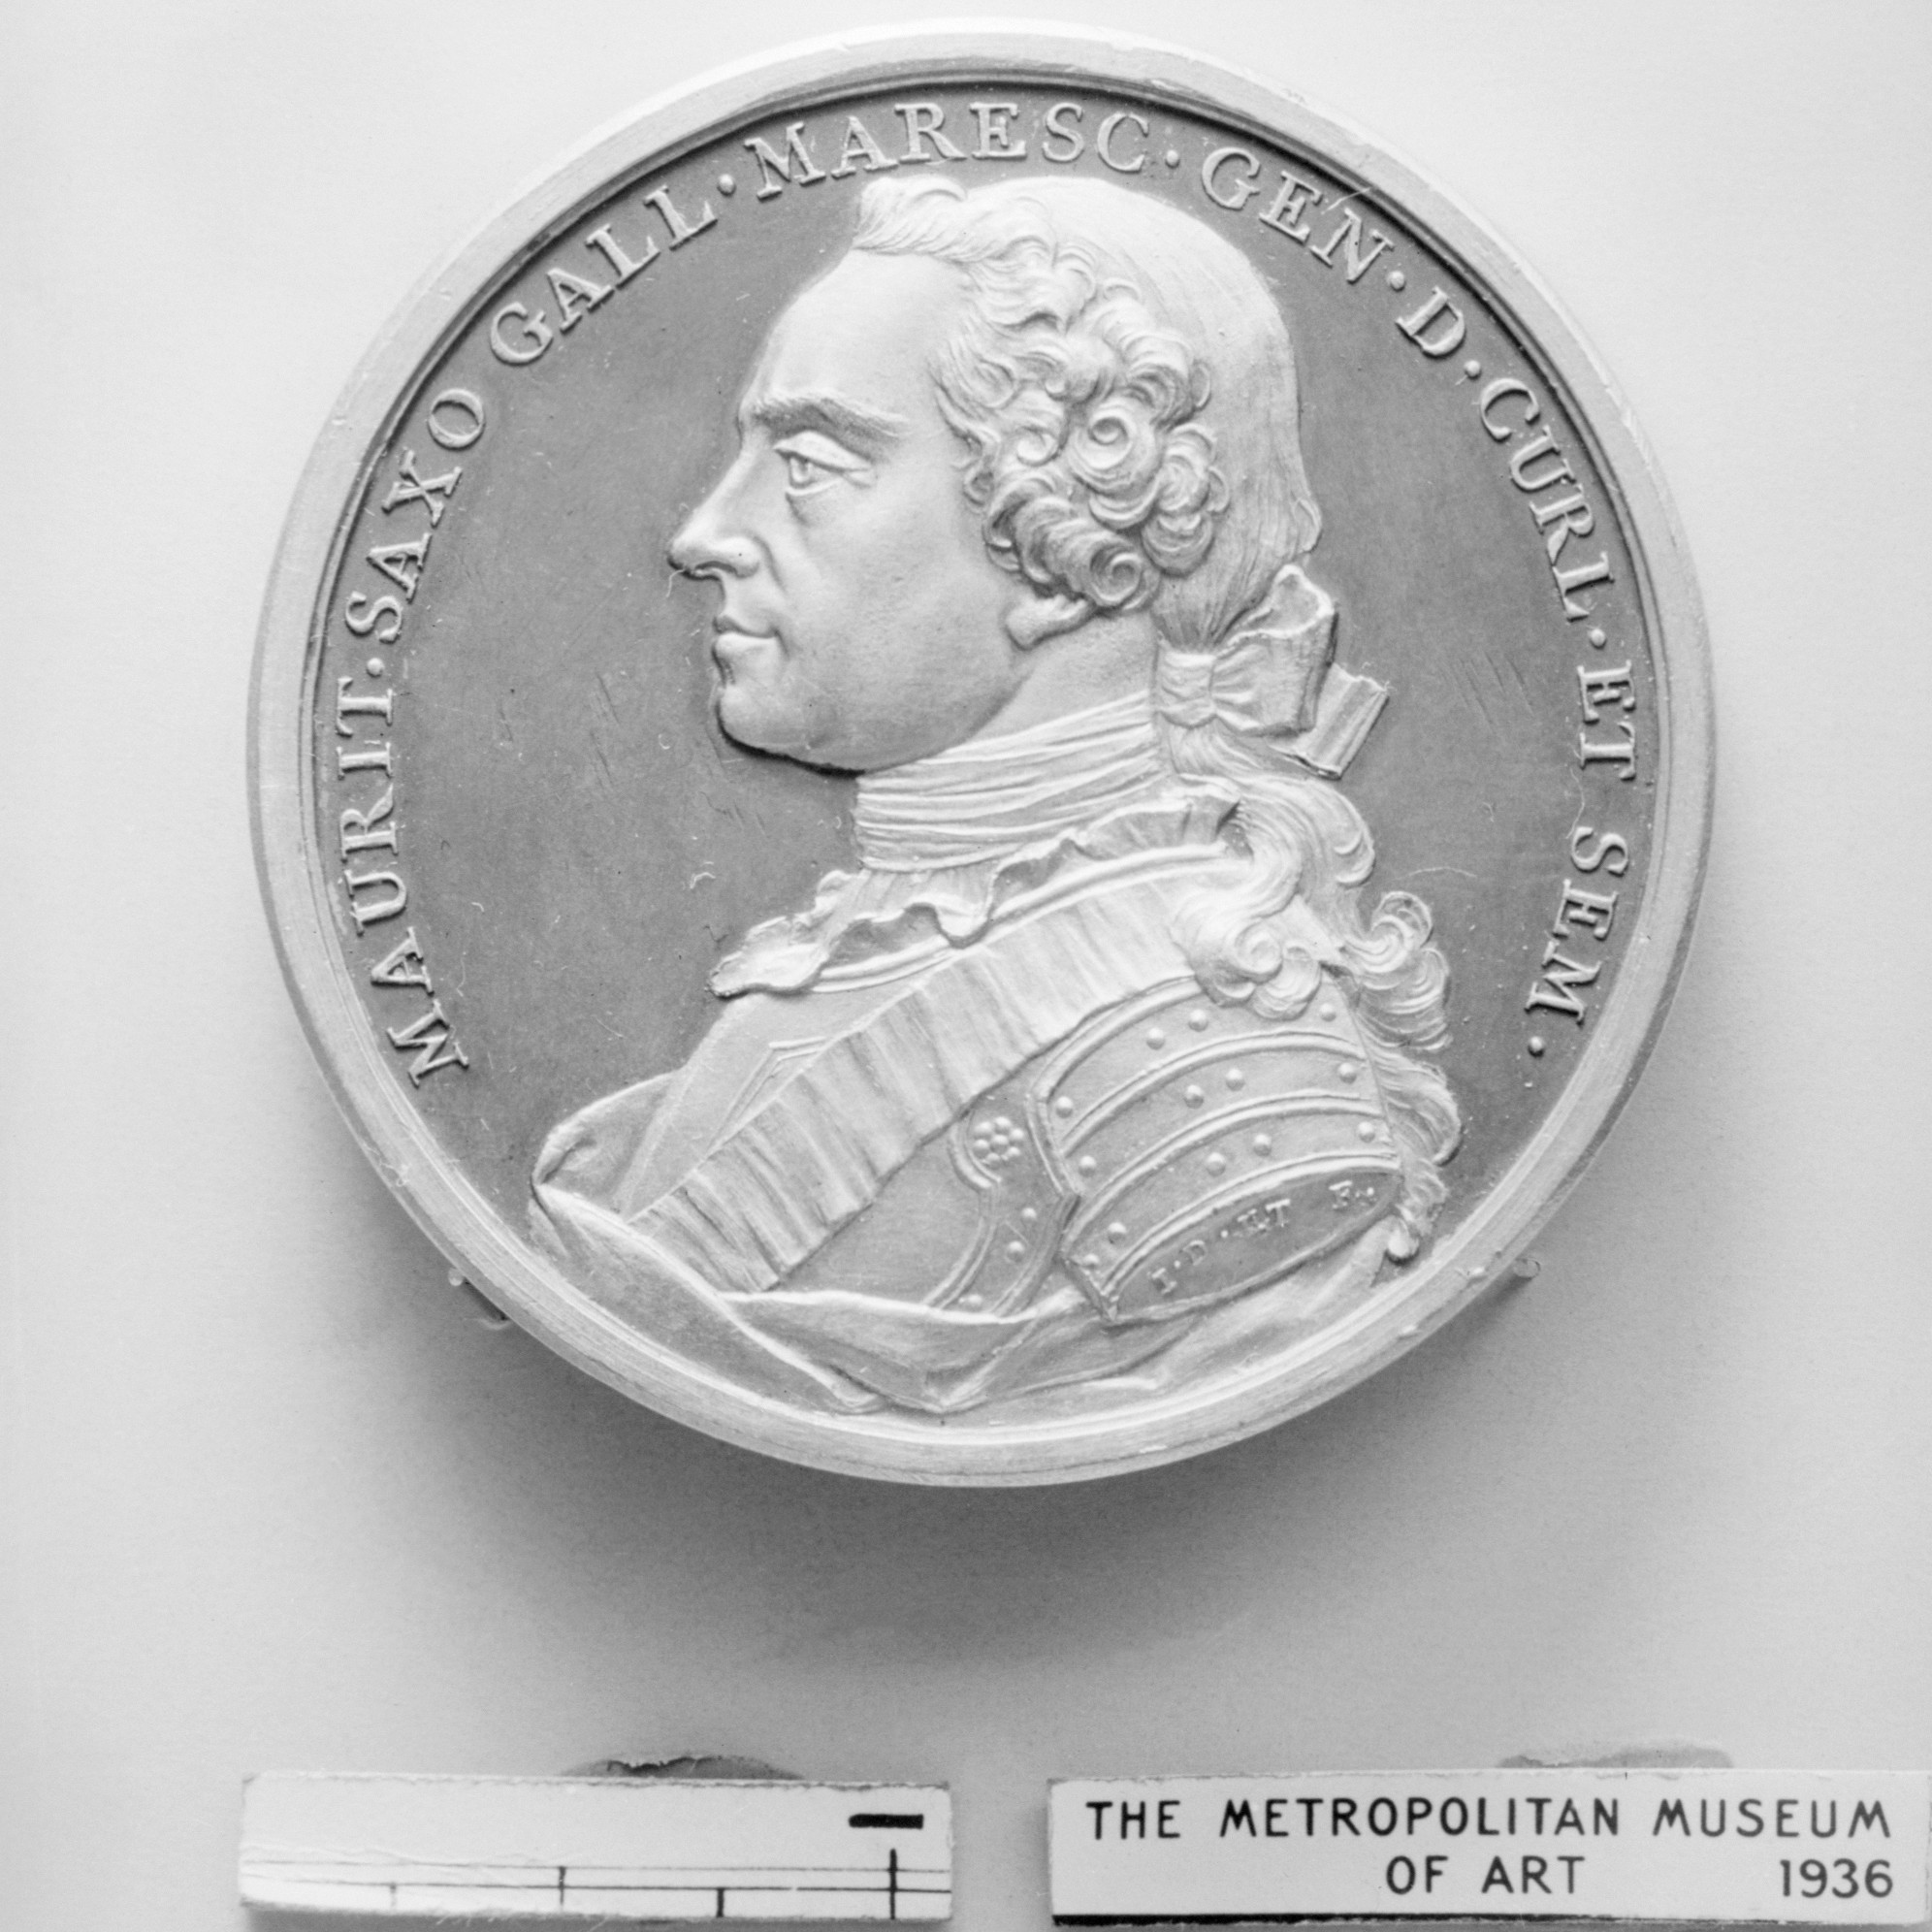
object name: medal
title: Count Maurice, Maréchal de Saxe (1696–1750)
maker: jean dassier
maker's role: artist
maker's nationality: swiss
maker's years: 1676-1763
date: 1747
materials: gilt bronze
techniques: lacquer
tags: men,profiles